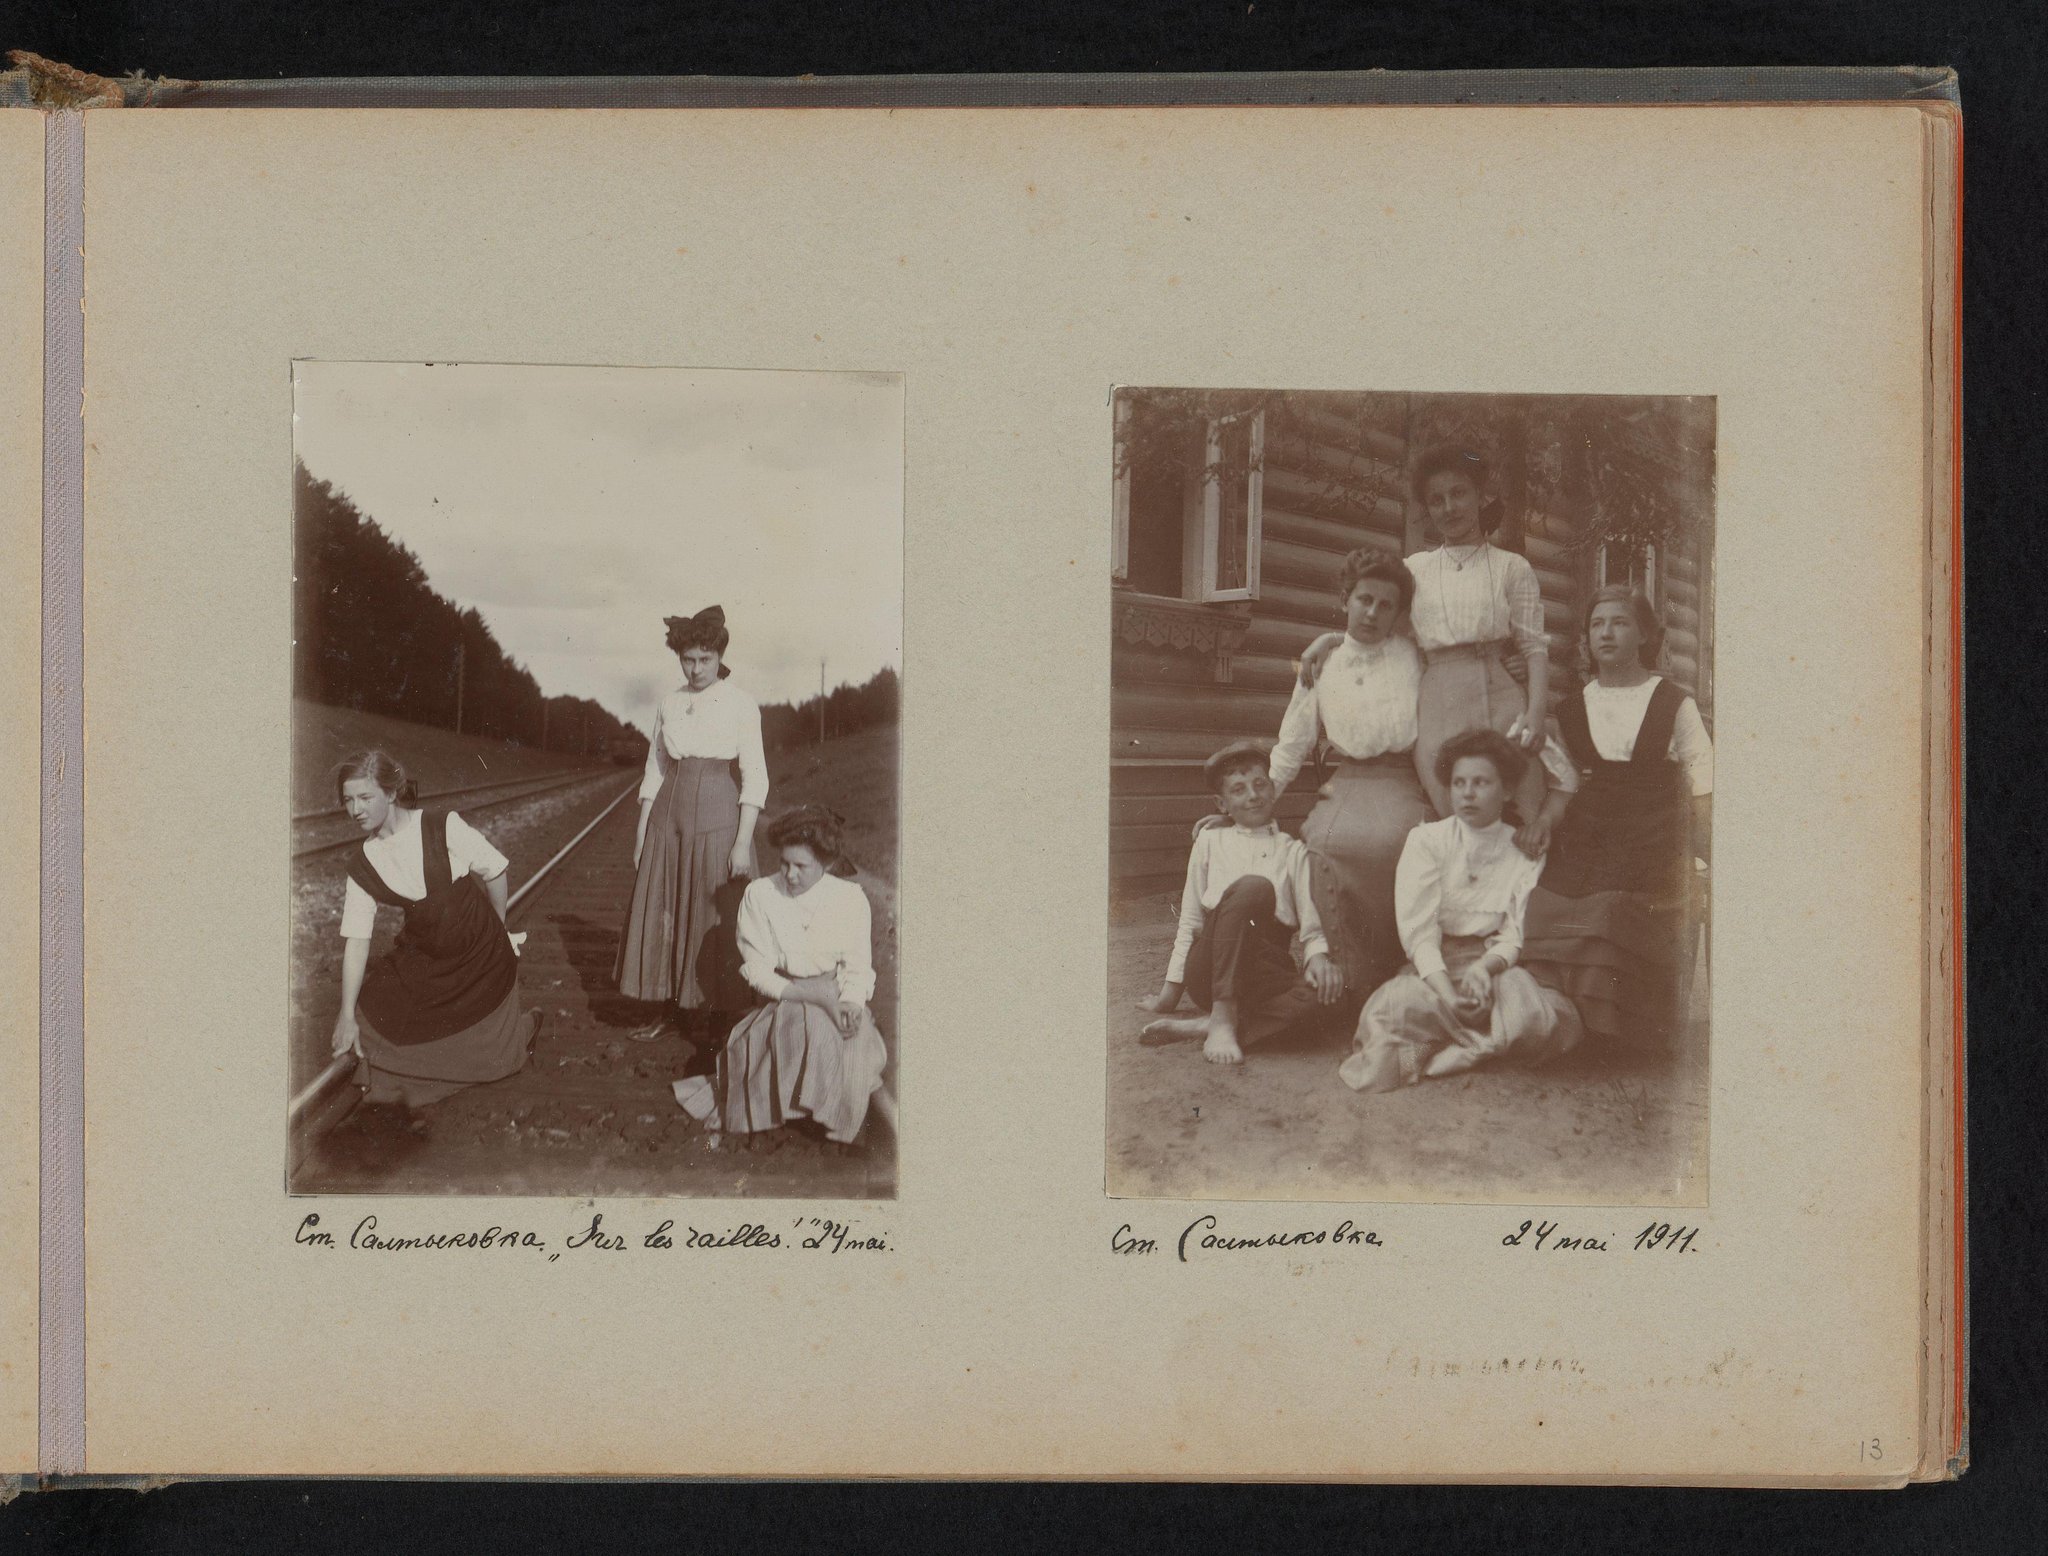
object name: album leaf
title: Drie vrouwen op een treinrails en portret van vier vrouwen en een jongen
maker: Anonymous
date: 1911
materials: paper, cardboard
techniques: collodion silver print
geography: russia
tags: historical persons, railway, train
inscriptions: inscription: ‘Cm. [...]. "Sur les railles" 24 mai.’, inscription: ‘Cm. [...]. 24 mai 1911.’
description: Deze foto's maken deel uit van een album.